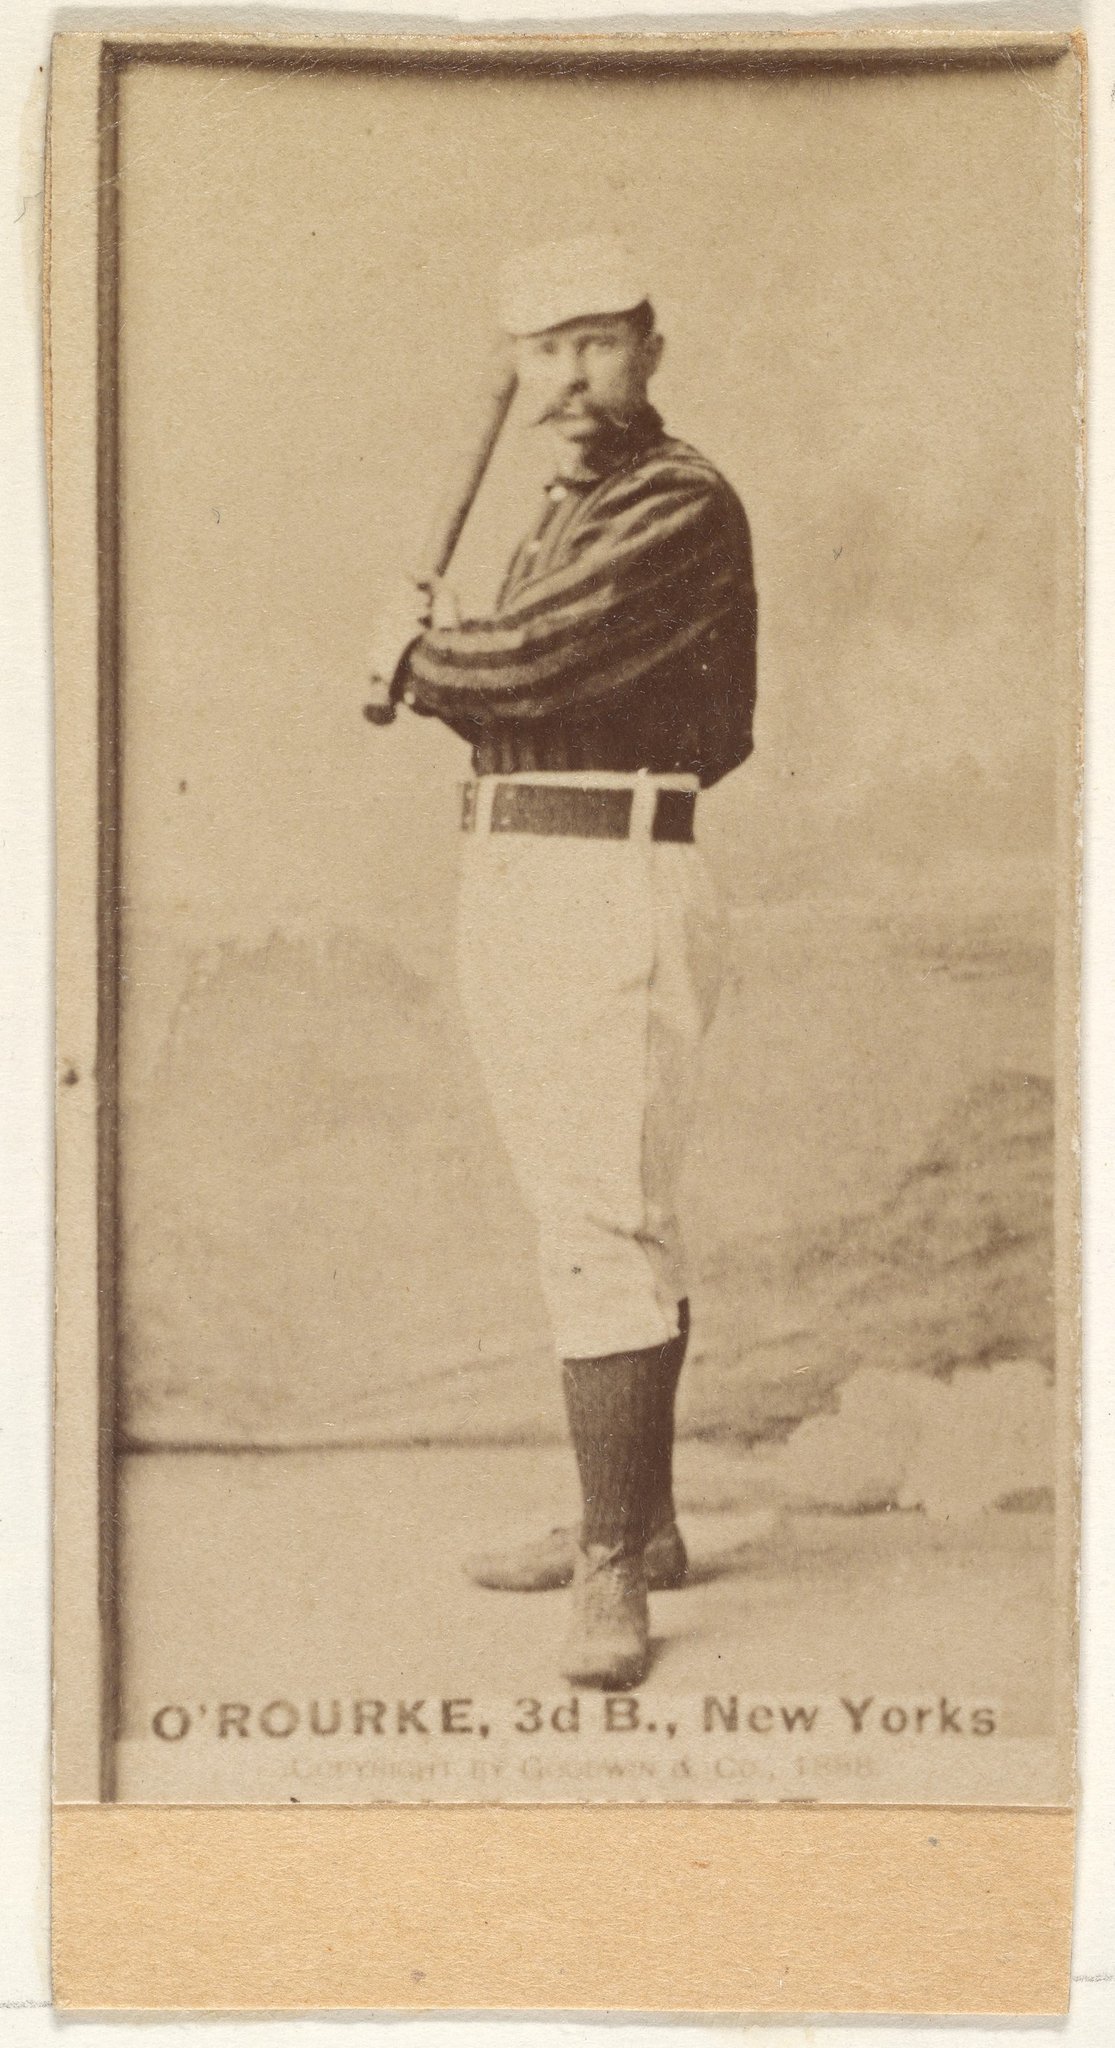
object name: baseball card, photograph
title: James Henry O'Rourke, 3rd Base, New York, from the Old Judge series (N172) for Old Judge Cigarettes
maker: goodwin & company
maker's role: publisher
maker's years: 1850-1950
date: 1888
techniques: albumen silver print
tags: men,portraits,baseball,athletes